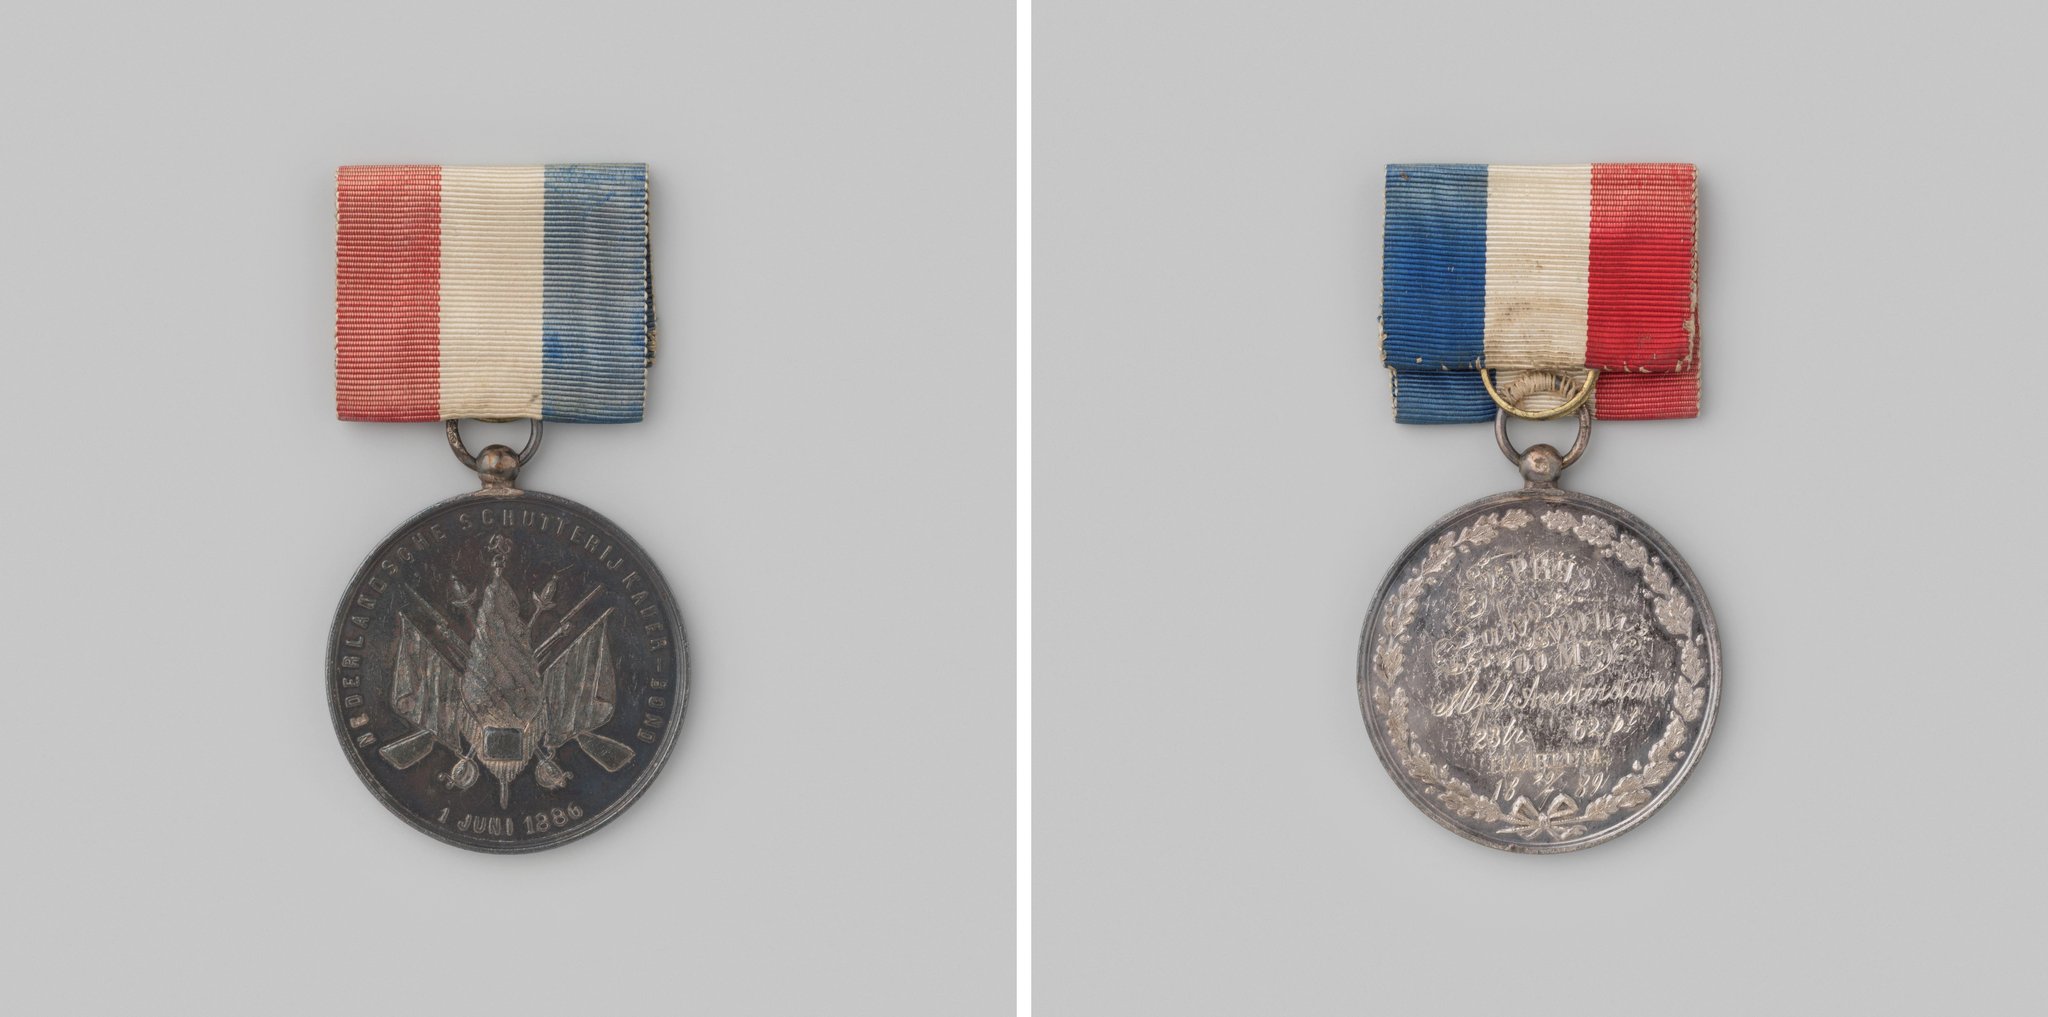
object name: draagpenning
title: Prijspenning van de Nederlandsche Schutterij-Kaderbond, 1889, salvovuur, tweede prijs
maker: Anonymous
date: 1889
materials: silver, textile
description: Zilveren penning. Prijspenning van de Nederlandsche Schutterij-Kaderbond, te Haarlem behaald, op 29 juli 1889. Rood-wit-blauw geribd zijden lint. Voorzijde: een trofee van wapens en vaandels gedekt door het korpsvaandel. Omschrift: NEDERLANDSCHE SCHUTTERIJ KADER BOND. 1 JUNI 1889. Keerzijde 2de PRIJS / Salvo-vuur / 200 M / Afd. Amsterdam / 23 tr. 62 pt / HAARLEM 18-89 29/7. Het geheel omgeven met eikenloof.